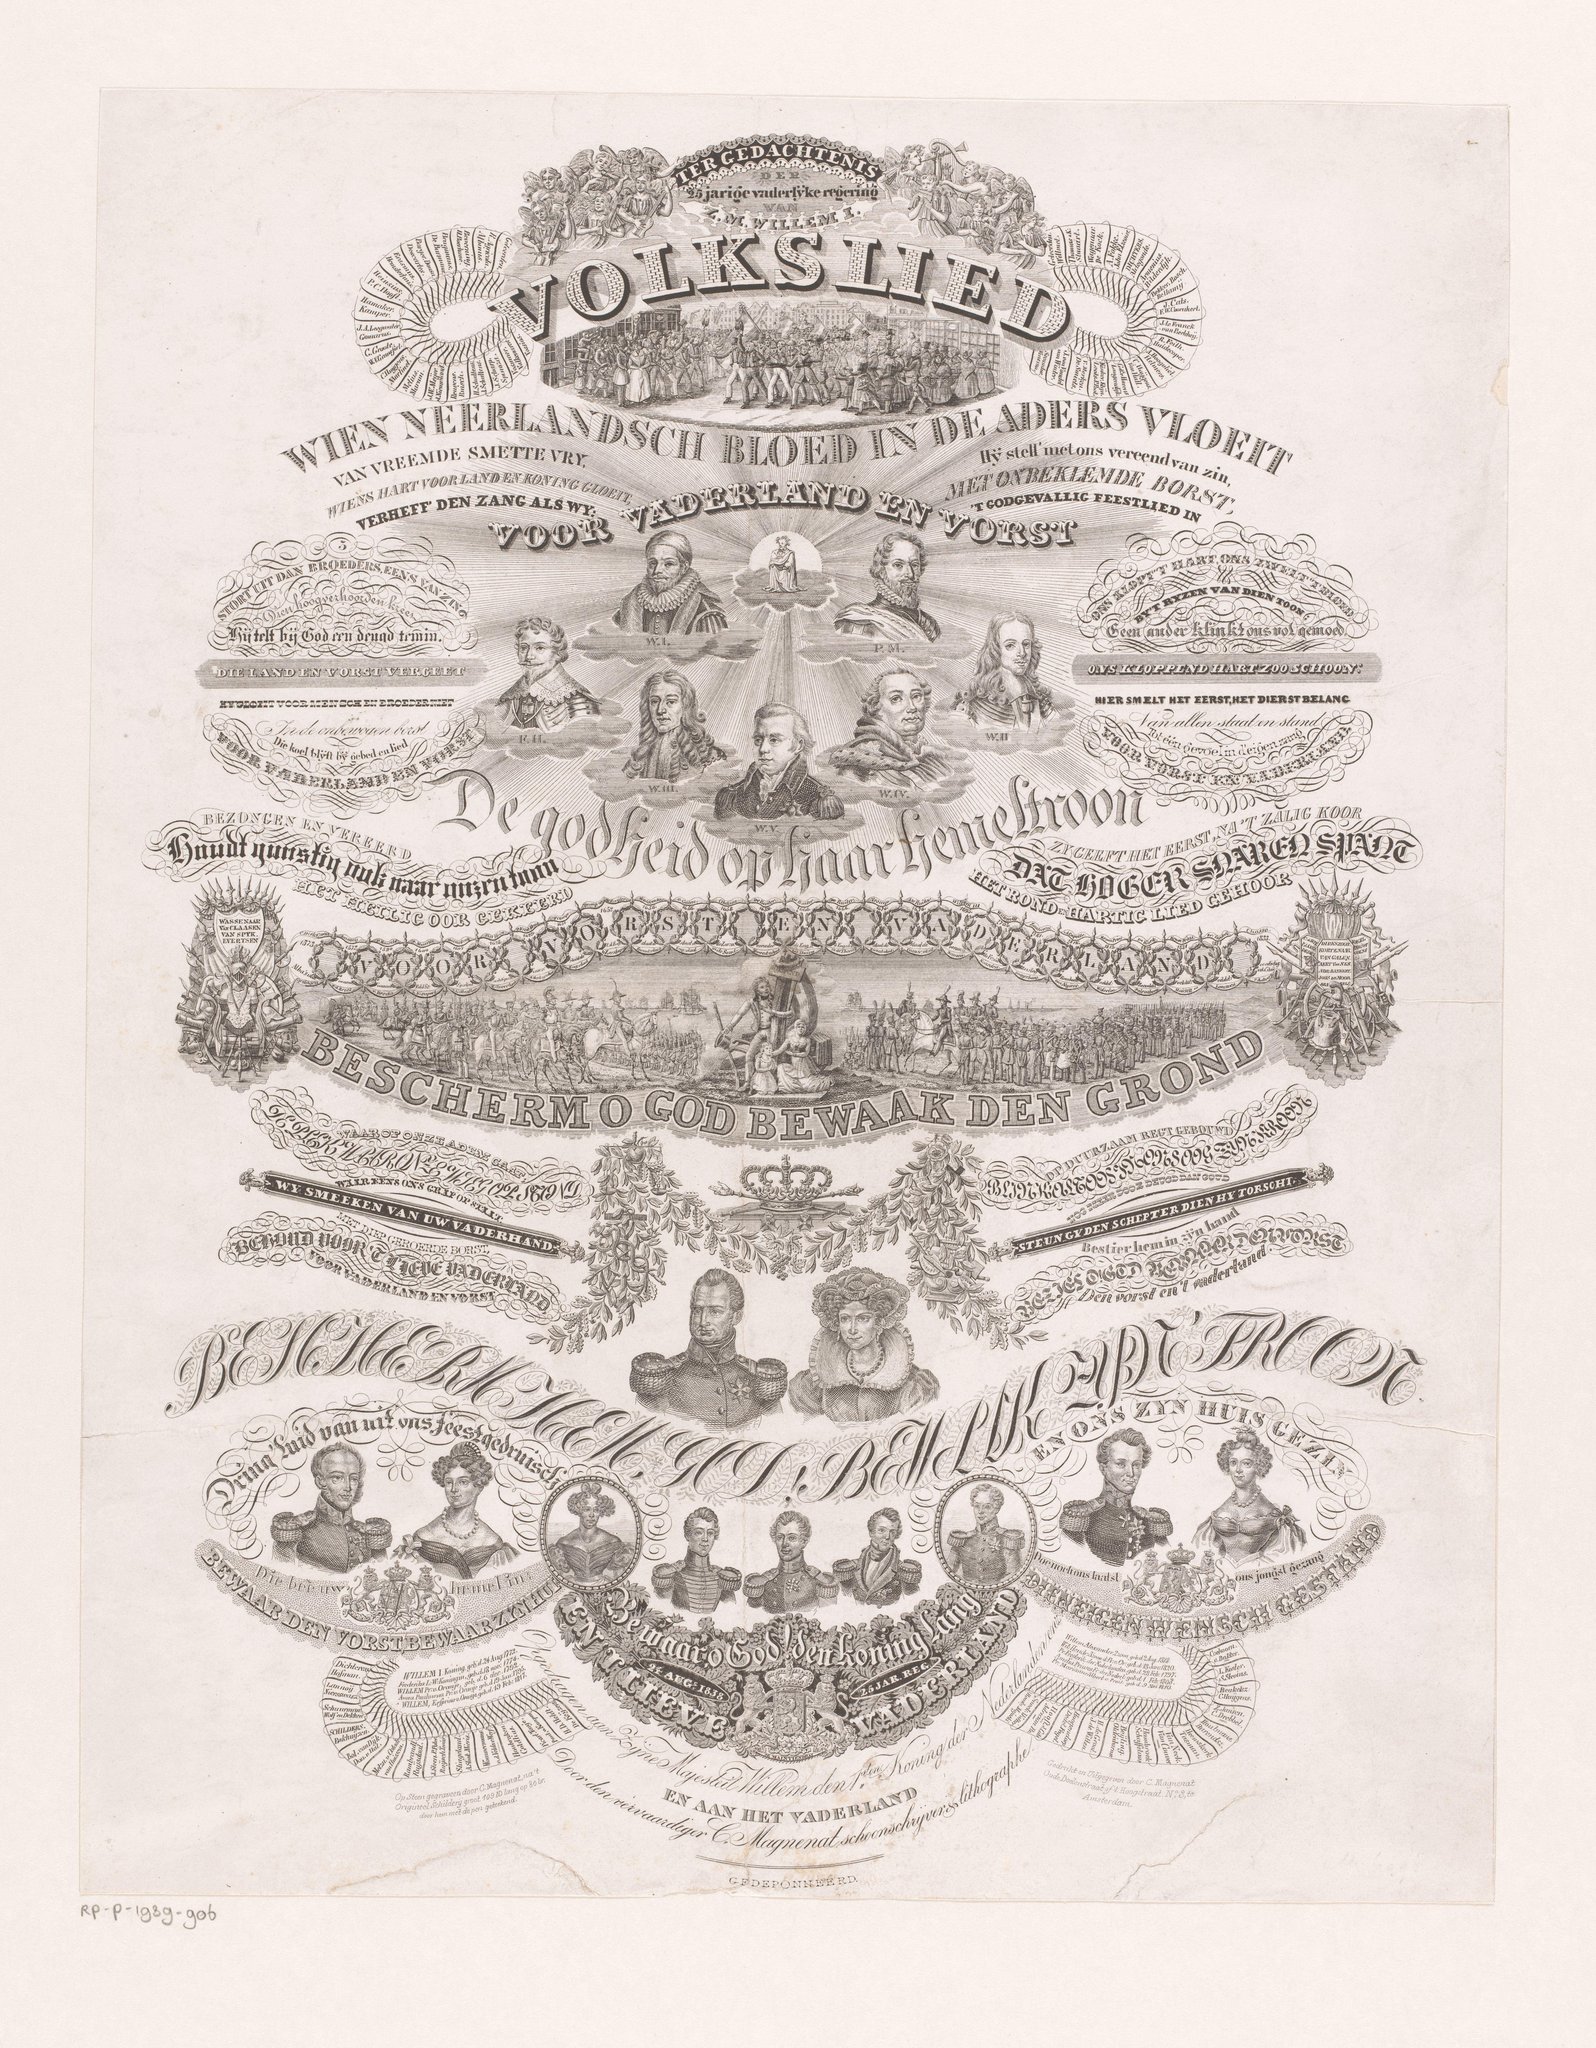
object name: print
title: Kalligrafie van het lied 'Wien Neêrlands Bloed' bij het vijfentwintigjarige regeringsjubileum van koning Willem I, 1838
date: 1838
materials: paper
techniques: lithograph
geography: amsterdam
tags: the hague, berlin, william i of the netherlands, patriotism, symbols of particular nations, states, districts, etc.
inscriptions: collector's mark: Lugt 2228, collector's mark: Lugt 2760, : ‘Gedeponneerd.’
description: Kalligrafische voorstelling op het vijfentwintigjarige regeringsjubileum van koning Willem I in november 1838. De coupletten van het lied 'Wien Neêrlands Bloed in de Aders vloeit' uitgevoerd in kalligrafie. Met portretten van alle leden van het Koninklijk Huis en eerdere stadhouders en prinsen van Oranje, vignetten en wapentrofeeën, festoenen en engelen. Bij de prent behoort een afzonderlijke verklaring en een bericht van intekening.